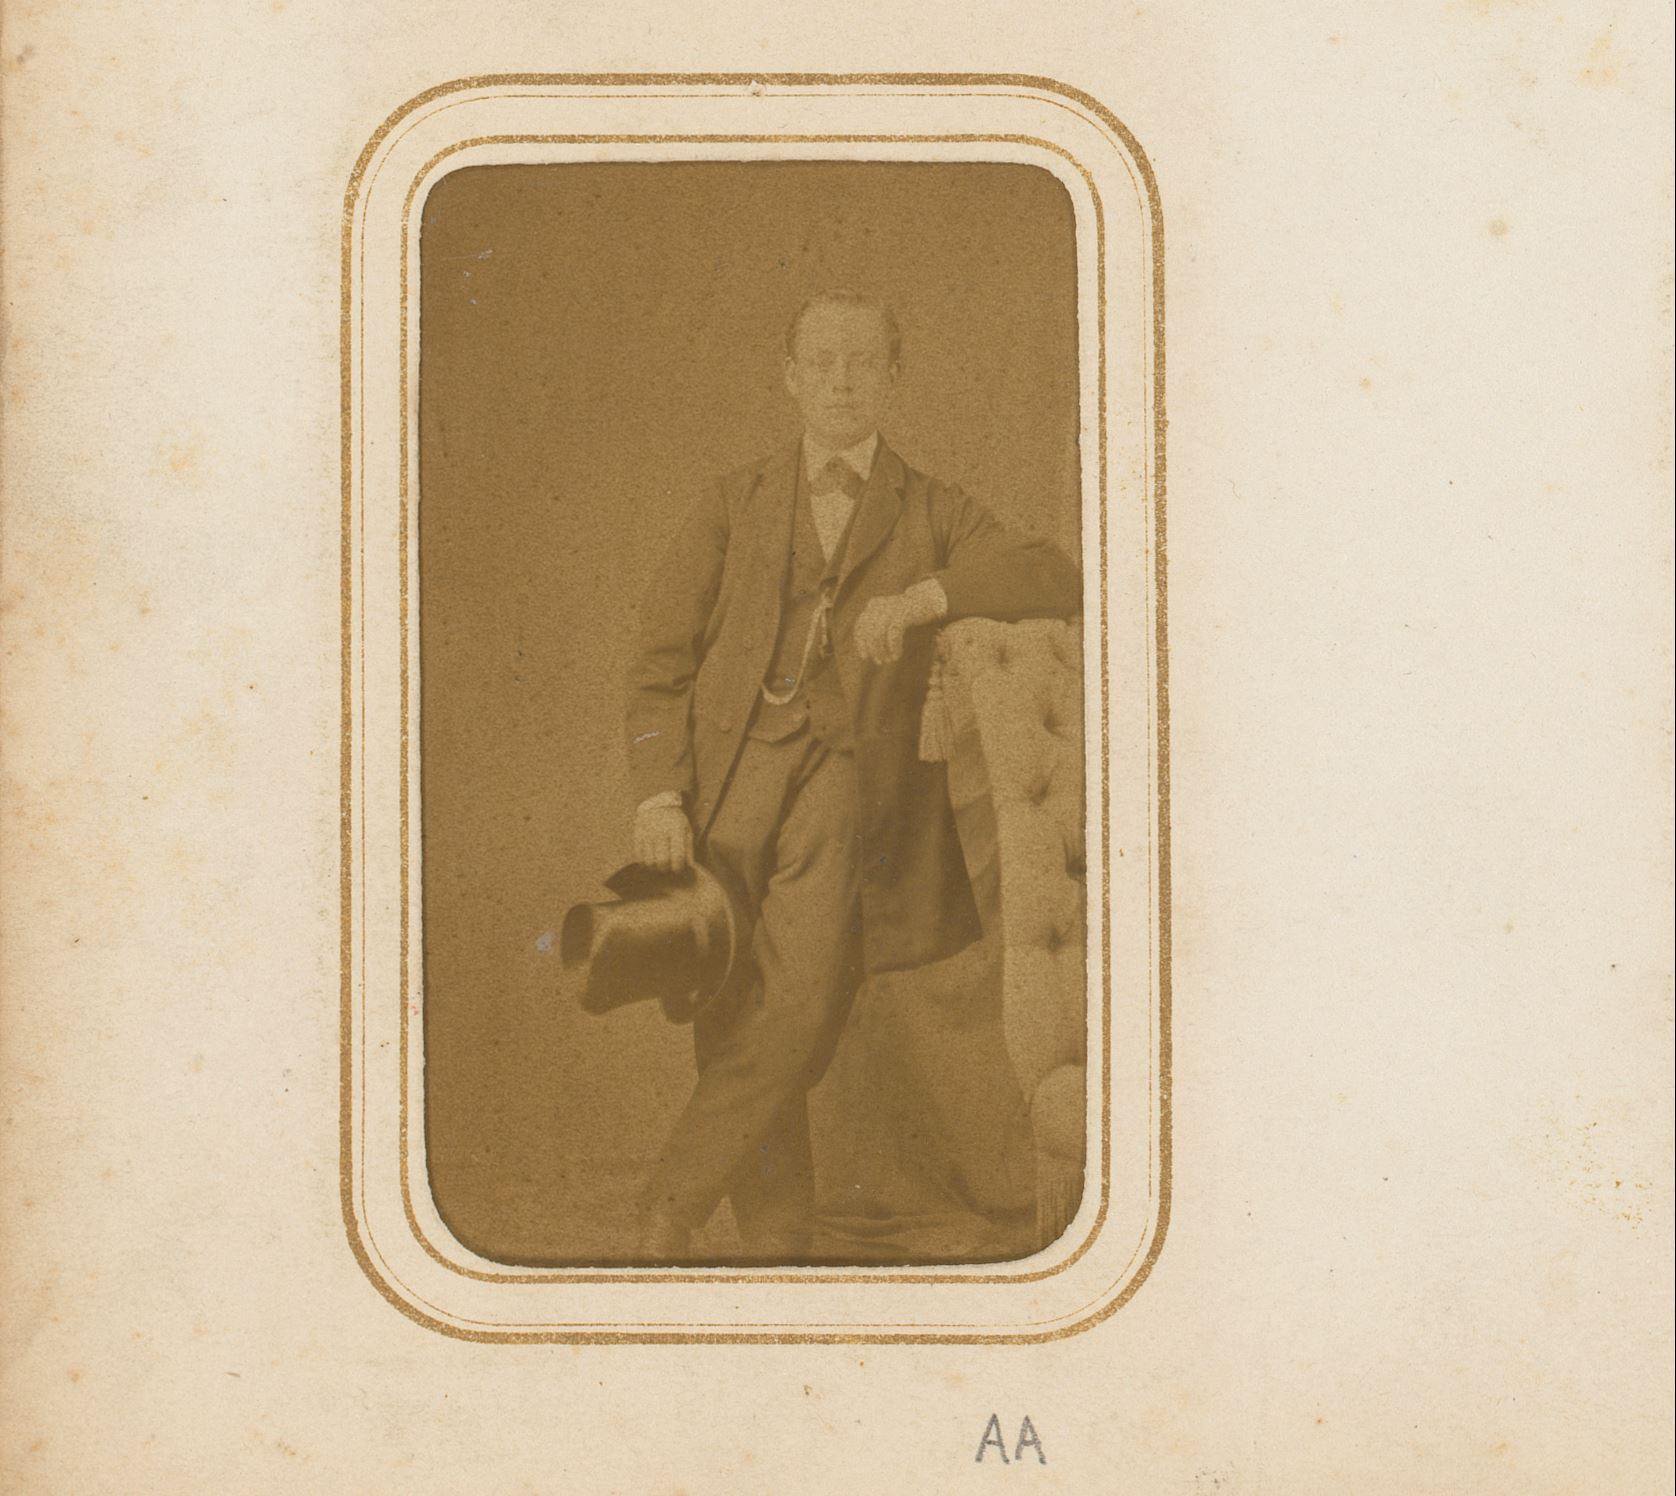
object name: photograph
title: Portret van een staande man met hoge hoed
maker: simon van caspel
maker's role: fotograaf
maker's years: 1843-1880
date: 1870-1877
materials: cardboard, photographic support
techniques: albumen print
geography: amsterdam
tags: historical persons, head-gear: top hat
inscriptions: inscription: ‘Photographisch Etablissement/ van/ S. van Caspel/ Wolvenstraat KK 228/ Amsterdam’